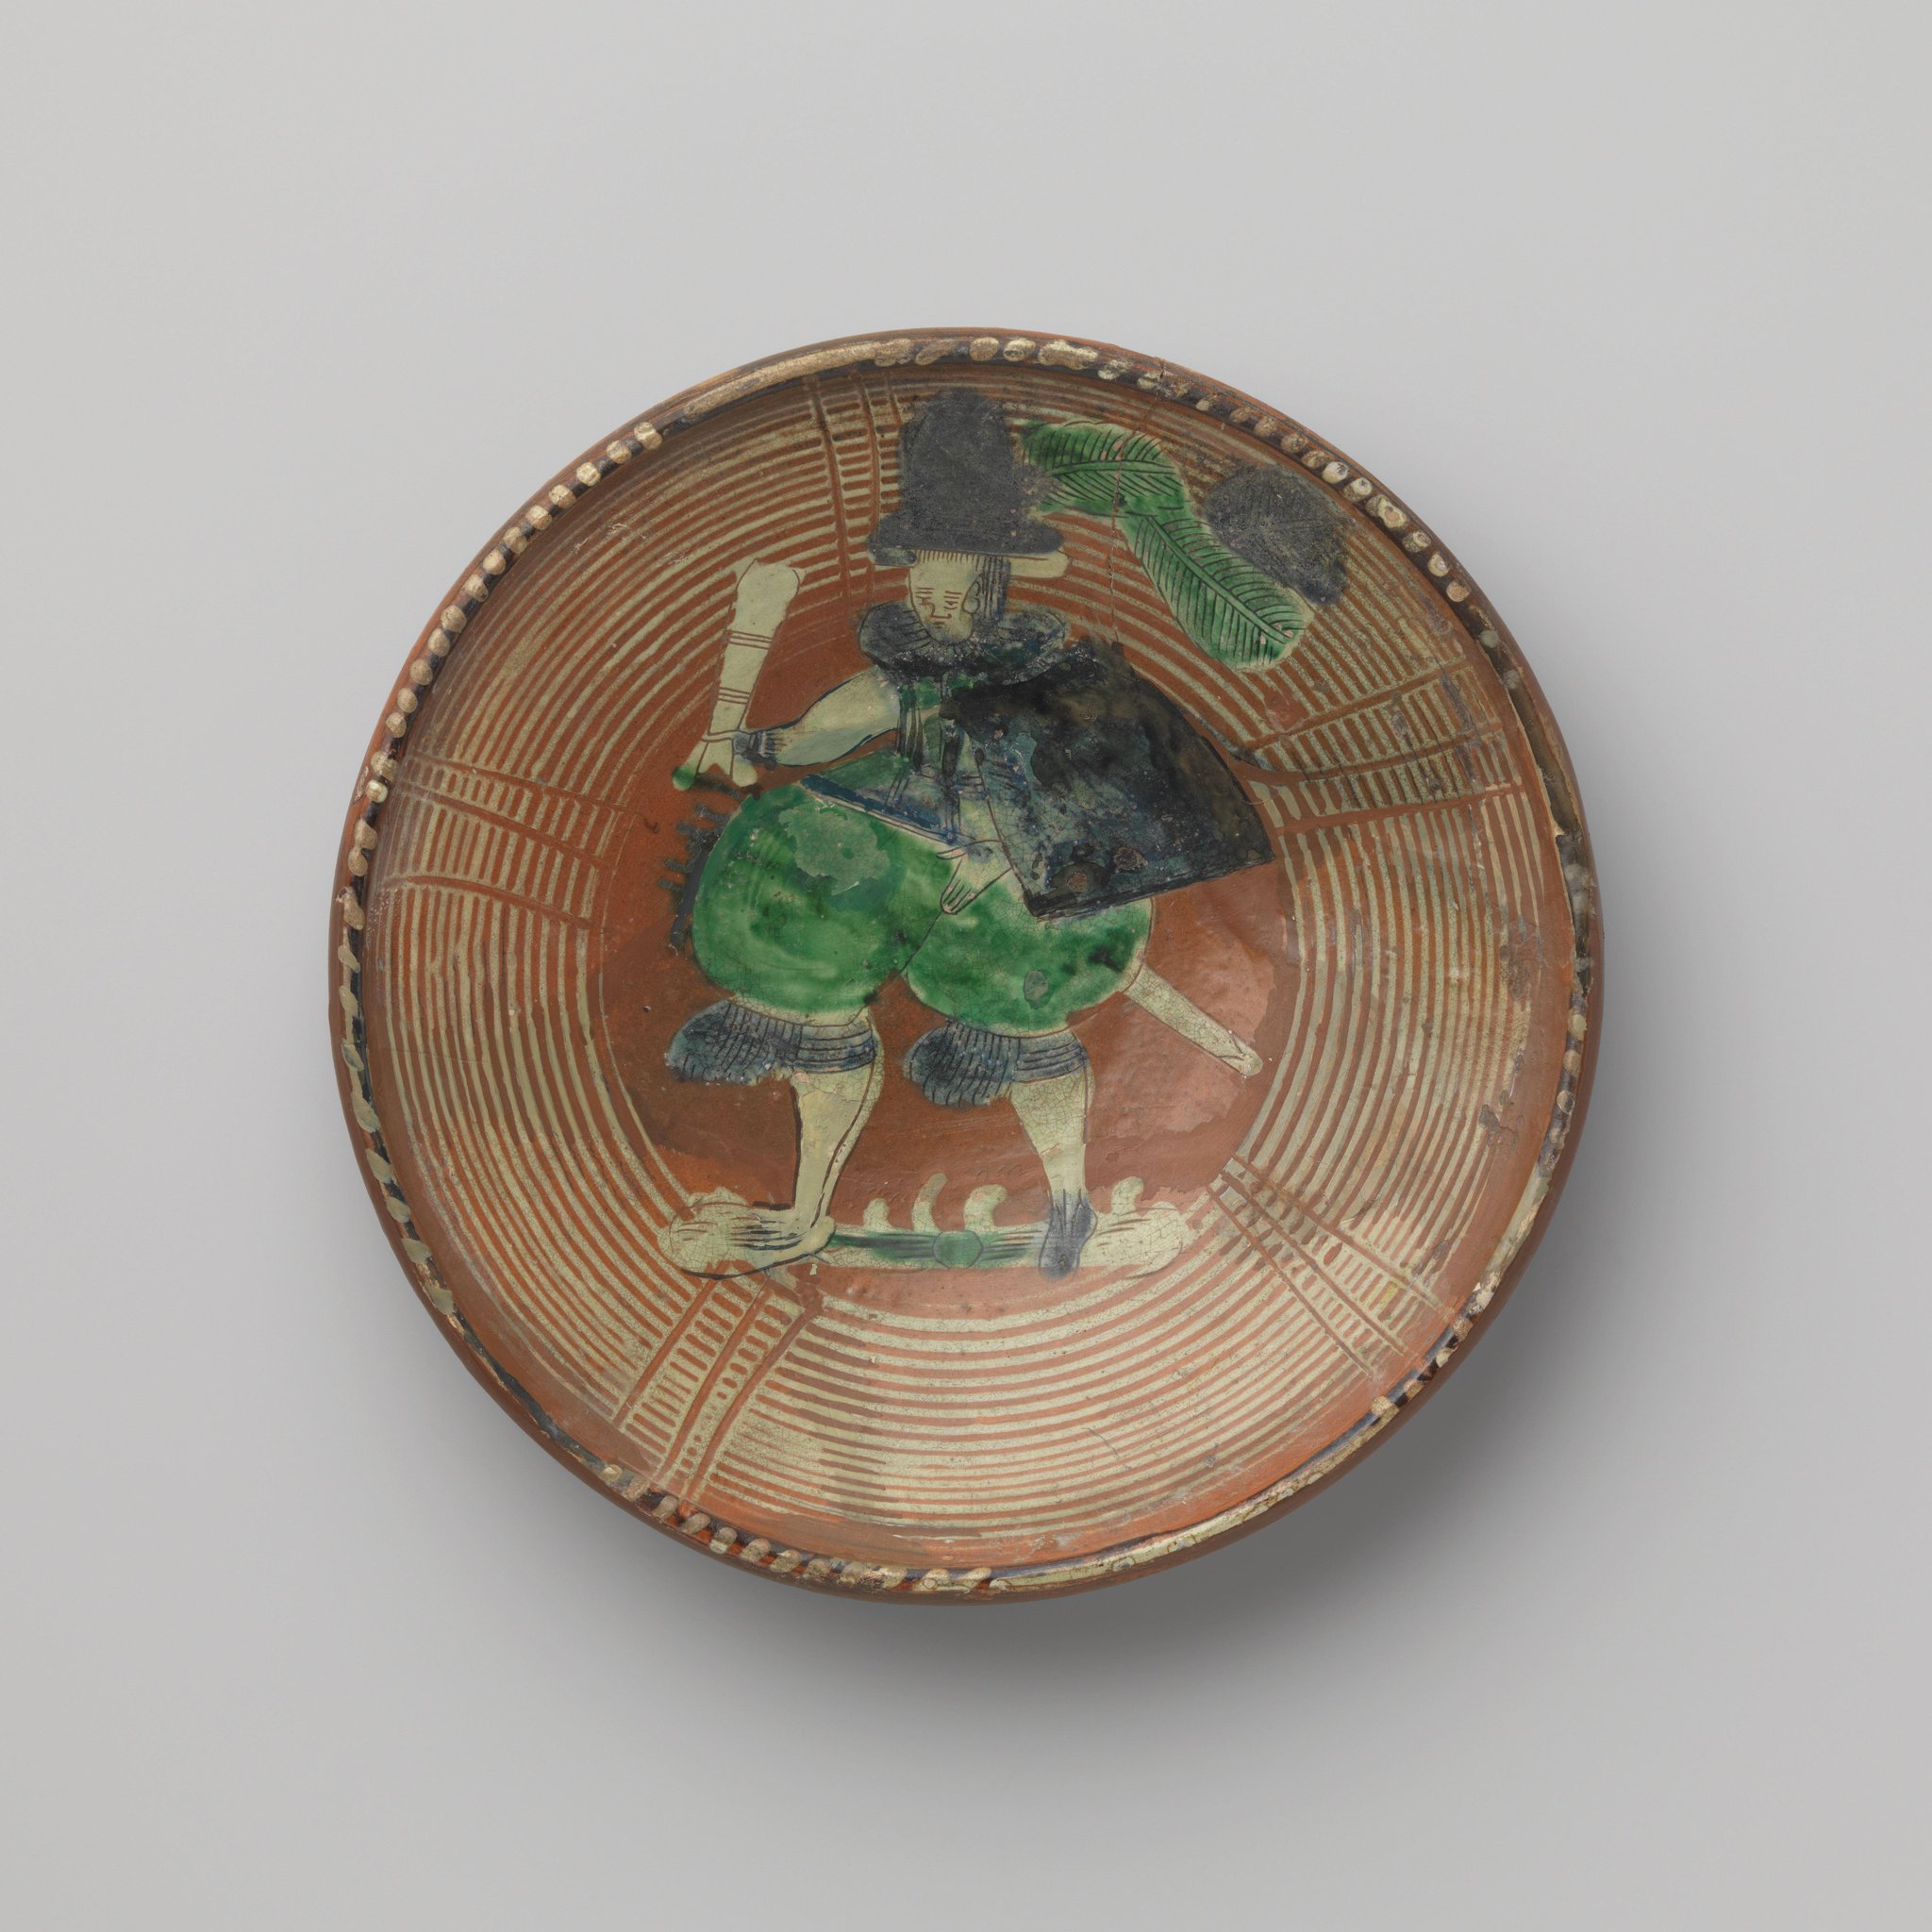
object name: platter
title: Schotel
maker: Anonymous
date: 1600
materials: earthenware, glaze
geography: wanfried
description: Ronde schotel van loodglazuuraardewerk. Op de schotel is een man ten voeten uit geschilderd. De man draagt een hoed met twee grote veren, een vest, een pijpkraag, een schoudermantel, een pofbroek en kousebanden met franje. In zijn rechterhand heeft hij een glas en op zijn linkerheup een degen. Langs de rand lopen vijftien concentrische cirkels, op enkele plaatsen straalsgewijs doorkrast door lijnen.